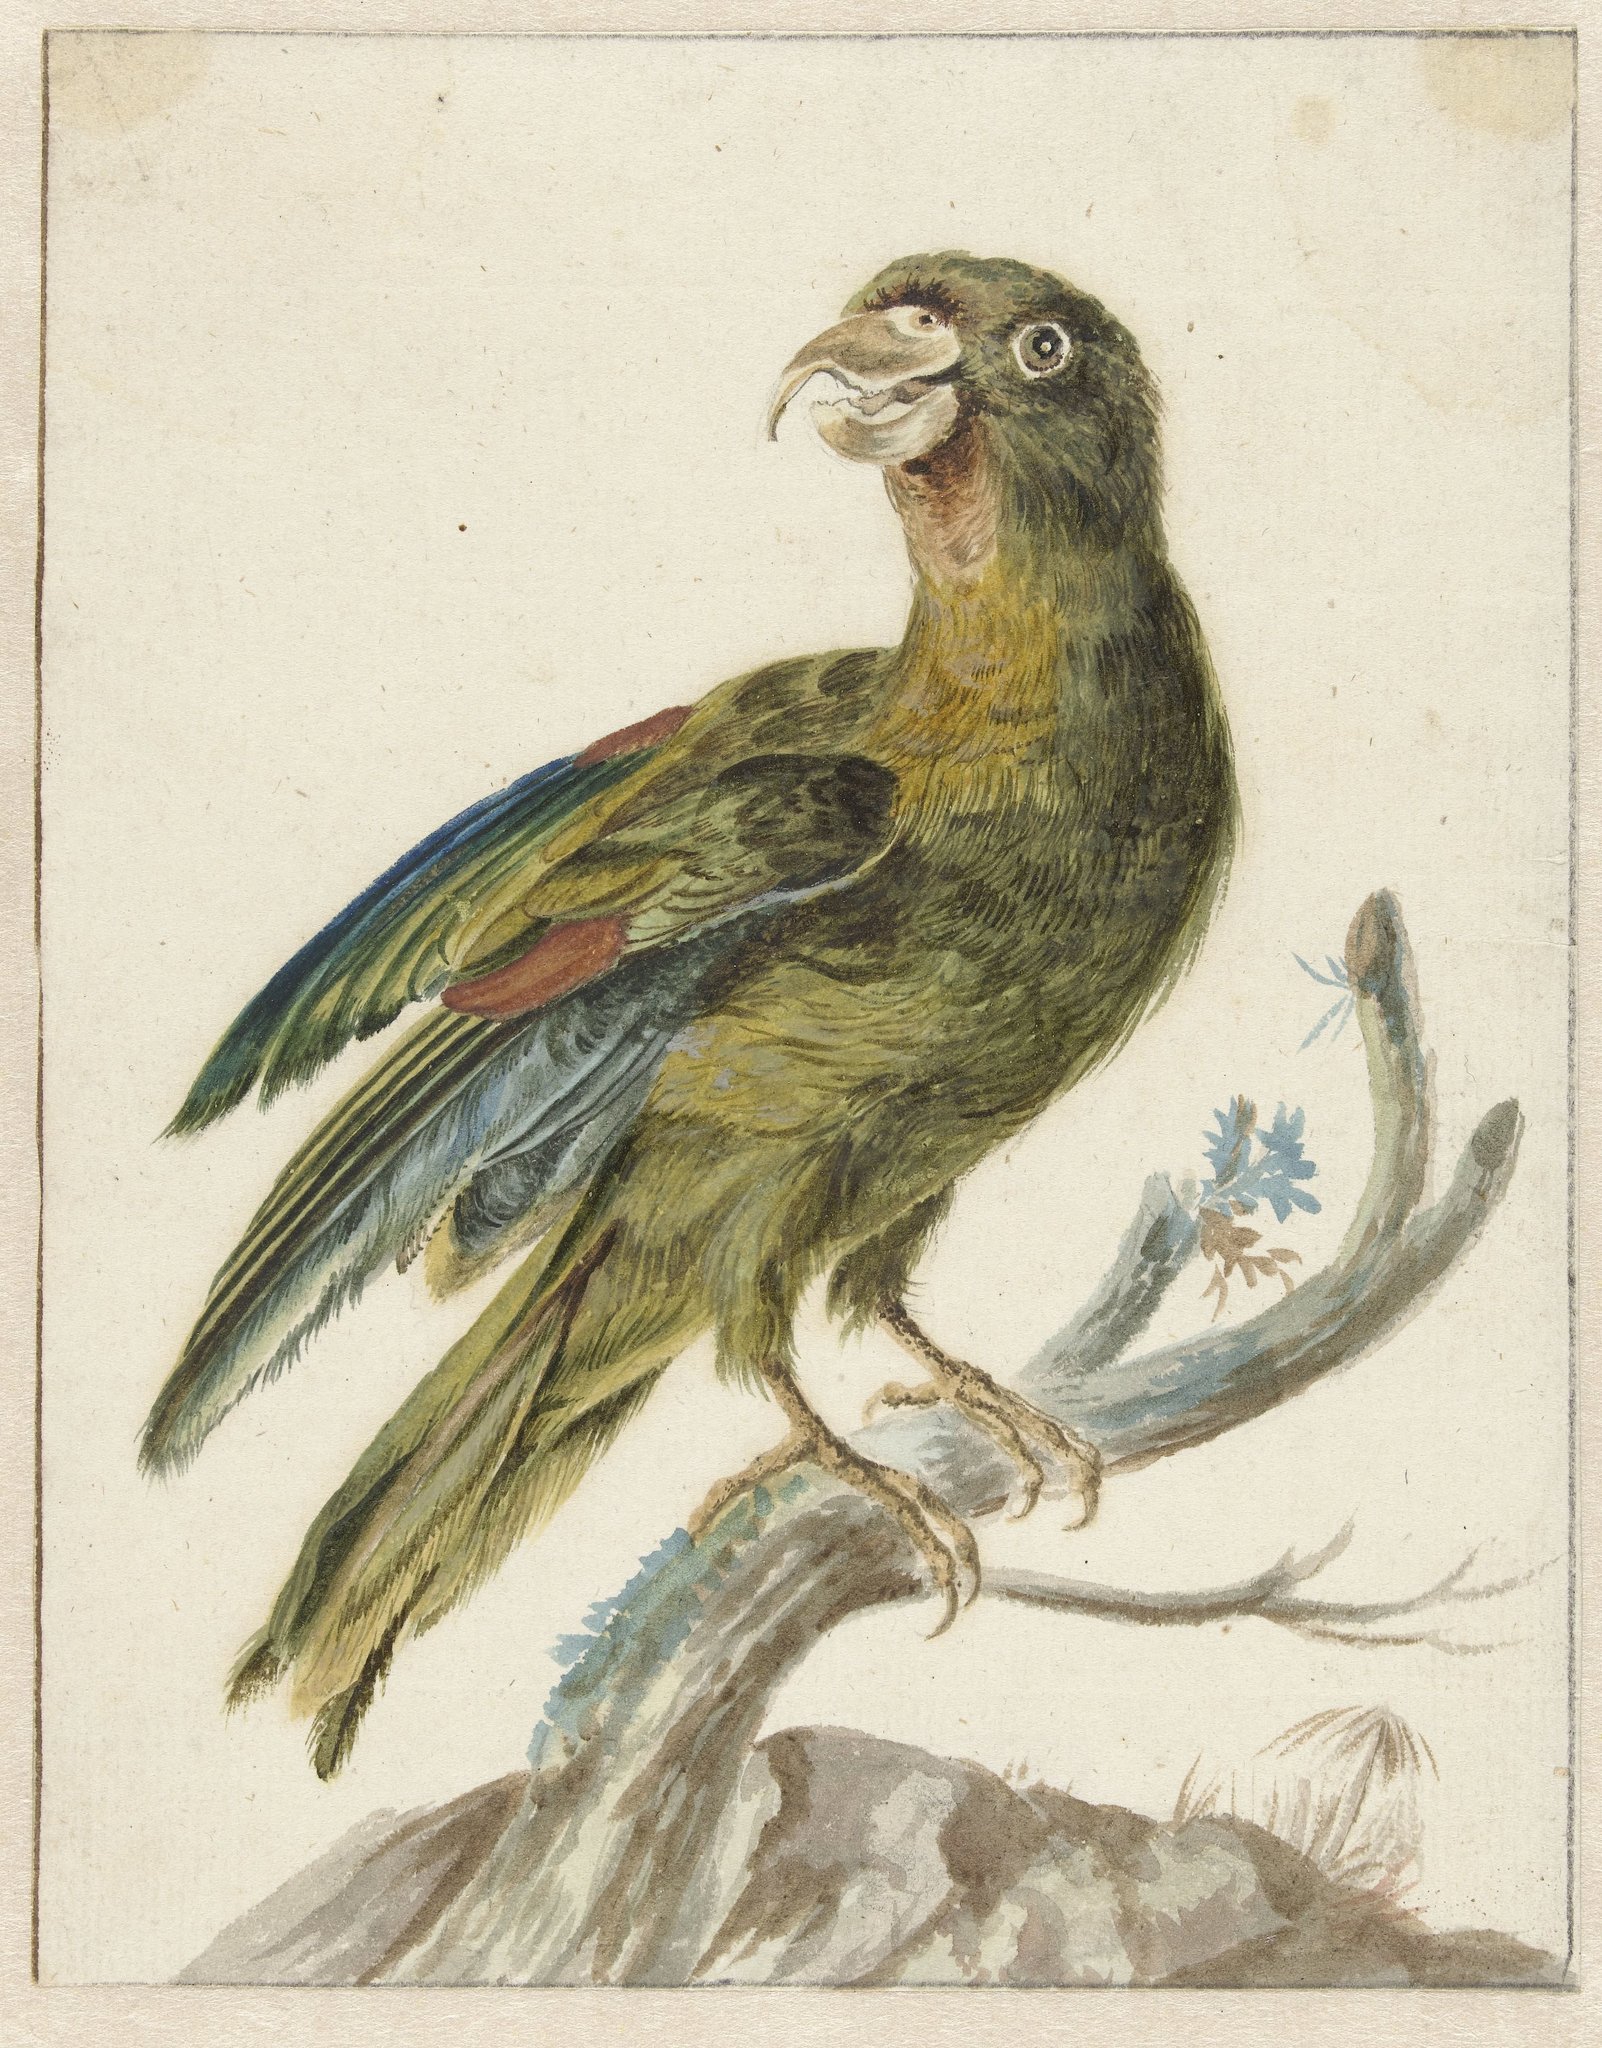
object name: watercolor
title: Parakeet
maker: jan weenix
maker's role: draughtsman, painter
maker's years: 1640-1719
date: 1670-1719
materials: paper, watercolor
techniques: brush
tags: ornamental birds: parakeet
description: Painters of bird and dead game pieces, like Jan Weenix and his nephew Mechior d’Hondecoeter, had all kinds of tricks for studying birds. For instance, they drew from stuffed specimens, possibly the case for these two drawings of exotic birds. They also may have used a kind of gallows-like framework to keep dead birds in the desired position to show off their feathers to best advantage.